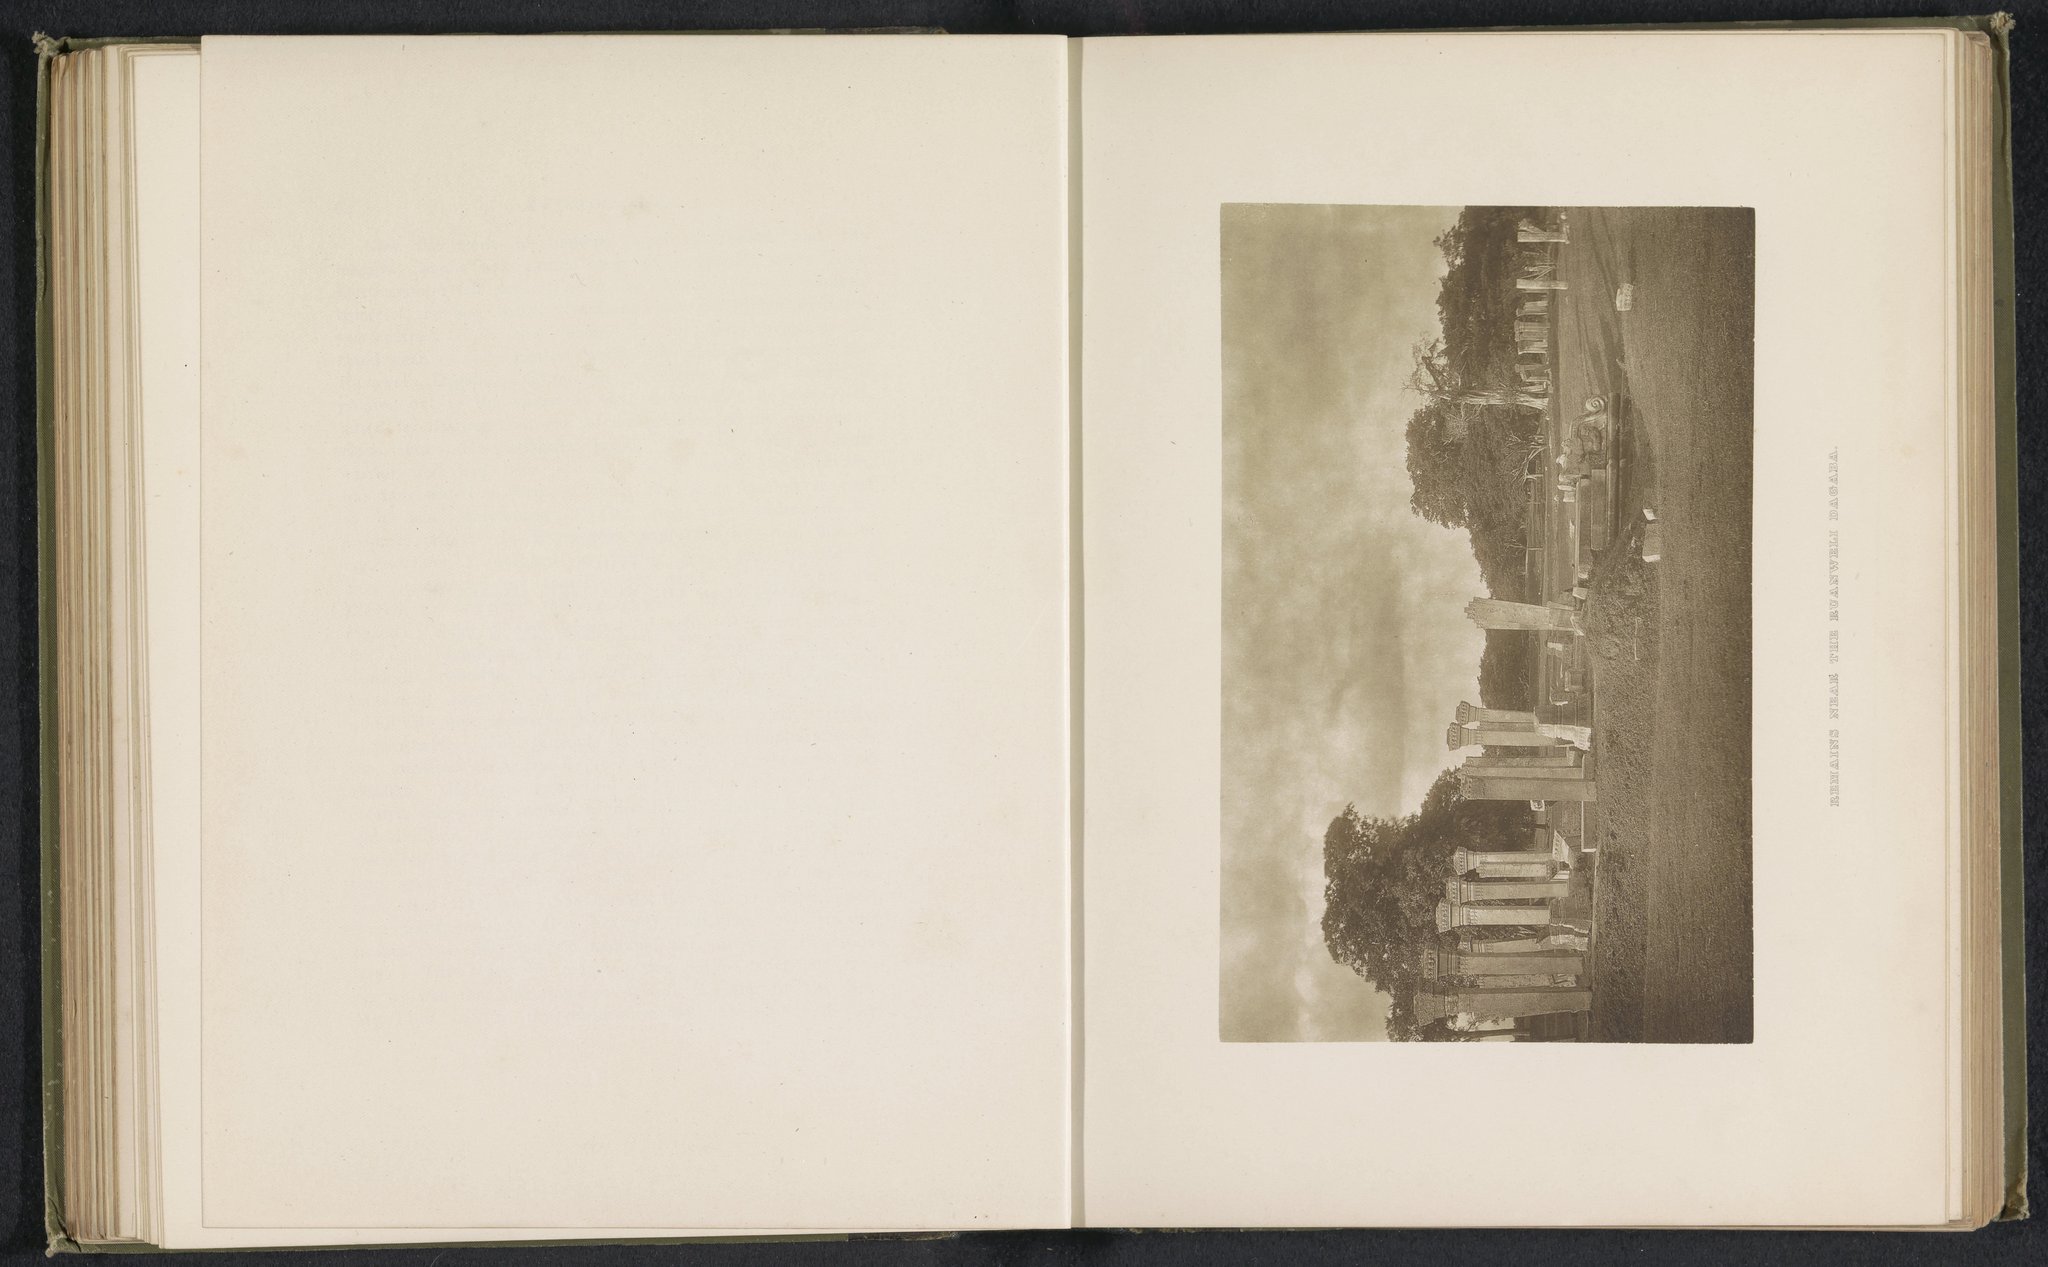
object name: page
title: Ruins near the Ruanwelisaya stupa at Anuradhapura, Sri Lanka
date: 1896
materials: paper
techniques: woodburygravure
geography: anuradhapura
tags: column, pillar ~ architecture, places and objects of worship ~ hinduism, buddhism, jainism, landscape with ruins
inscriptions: title: ‘RUINS NEAR THE RUANWELI DAGABA.’